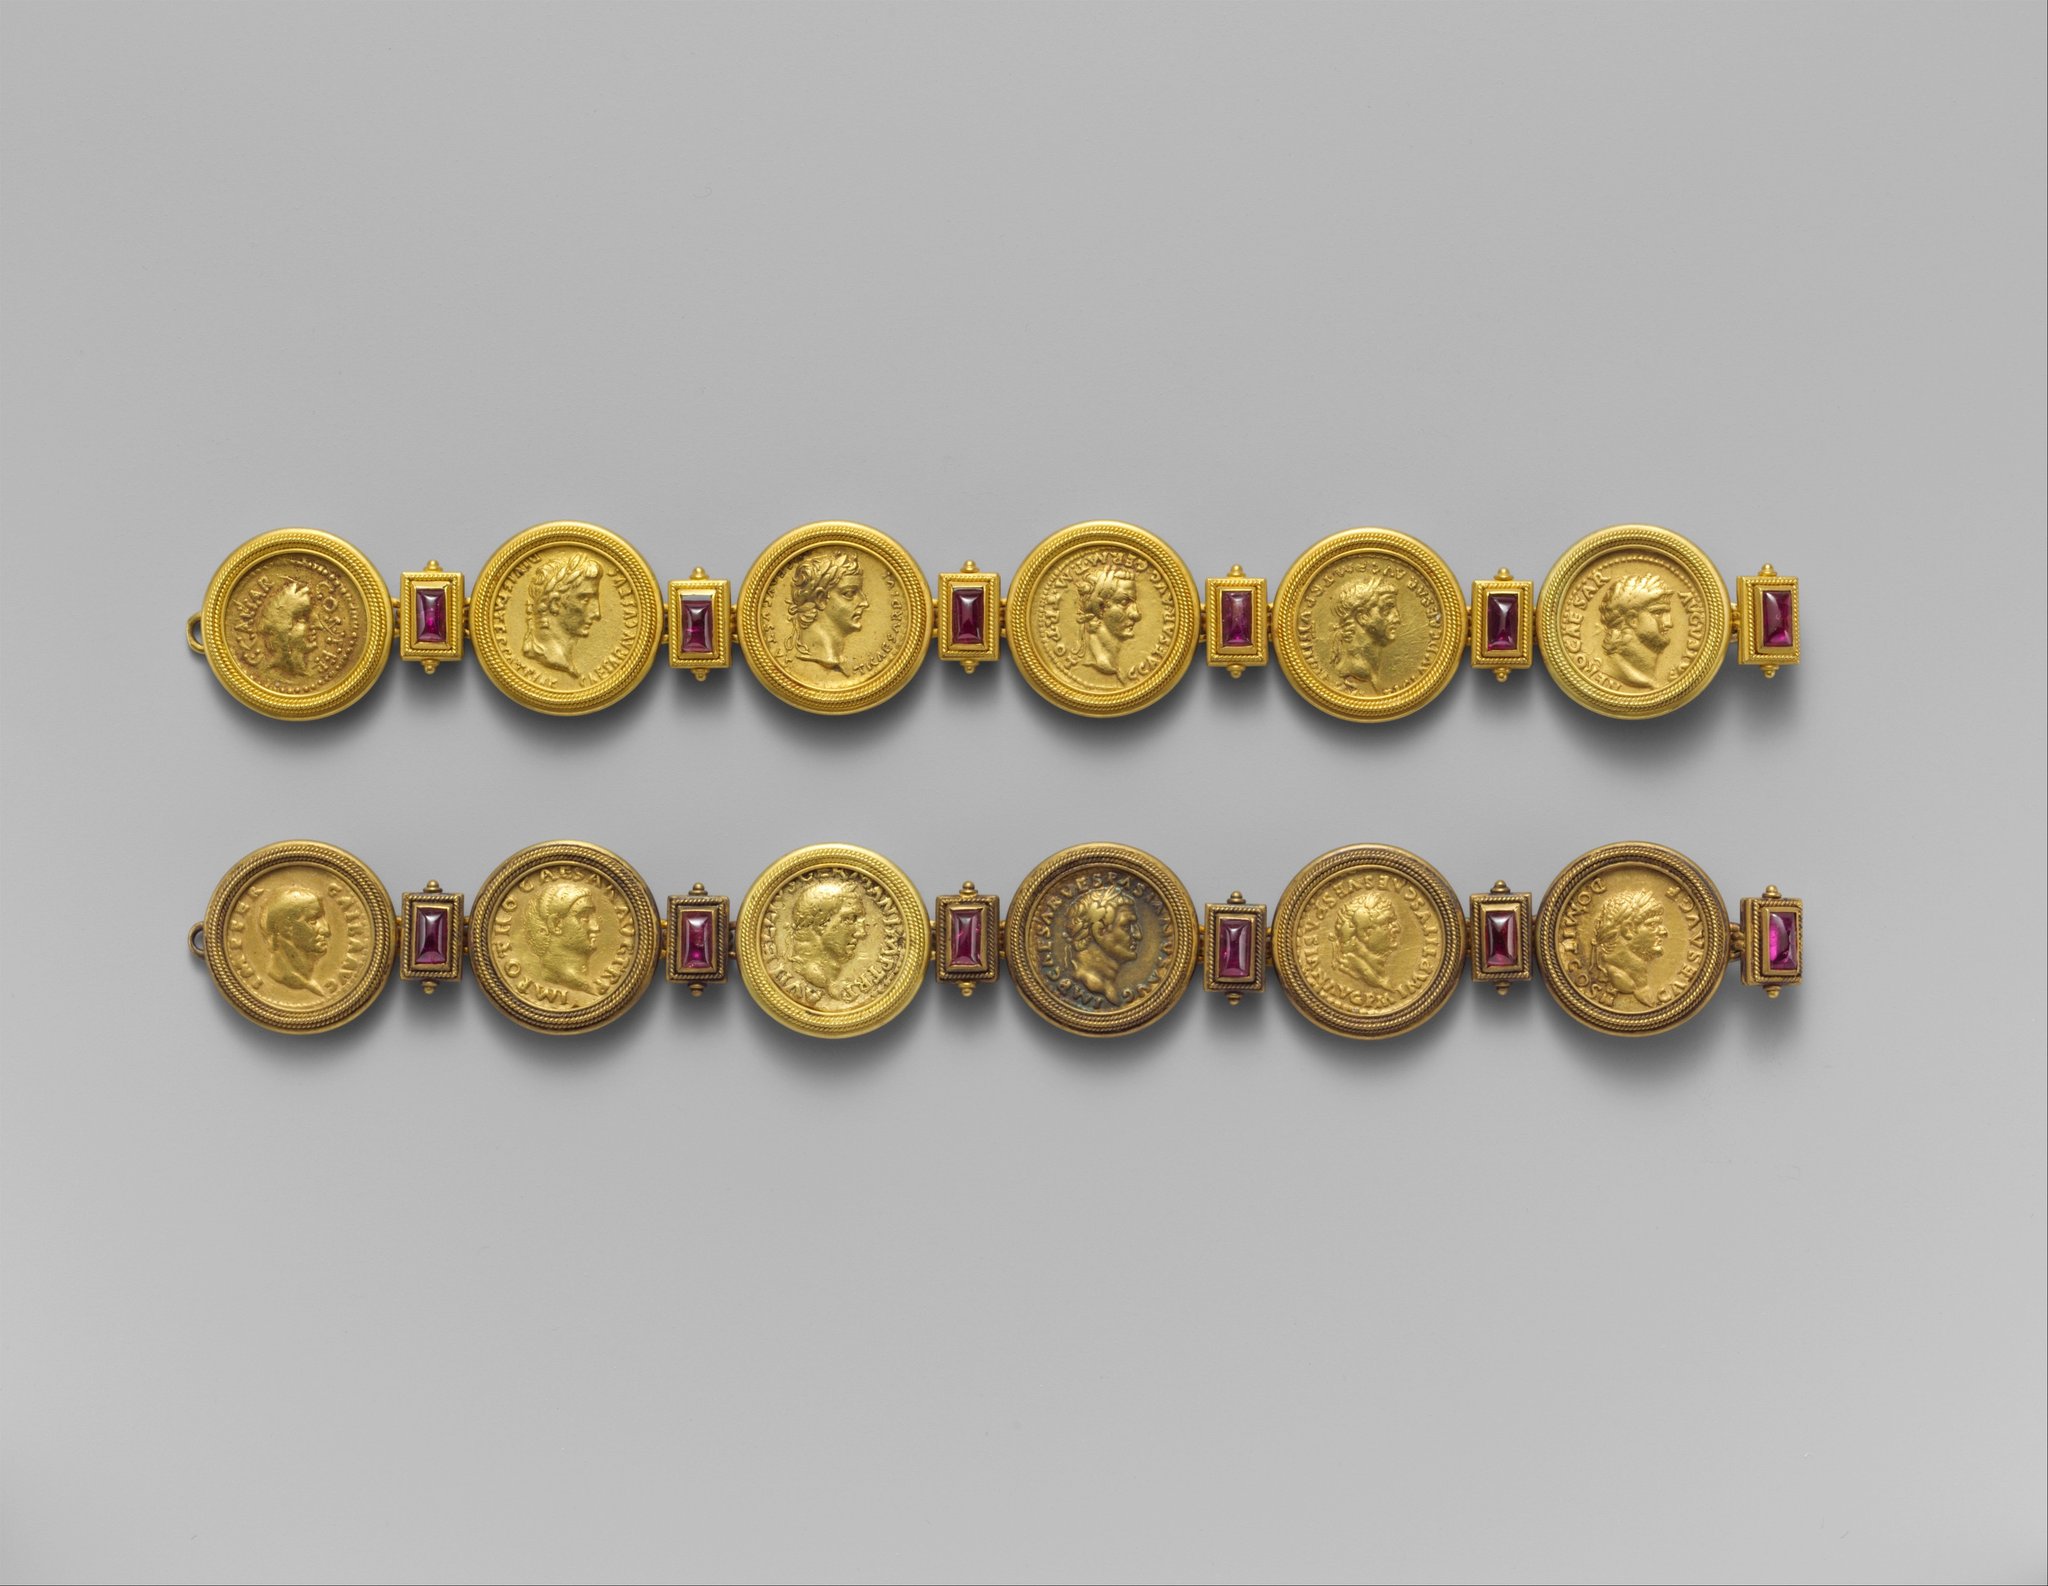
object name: aurei, 6 in bracelet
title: Gold aurei of the Twelve Caesars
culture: roman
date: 46 BCE-96 CE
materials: gemstone, gold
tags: emperors,men,profiles